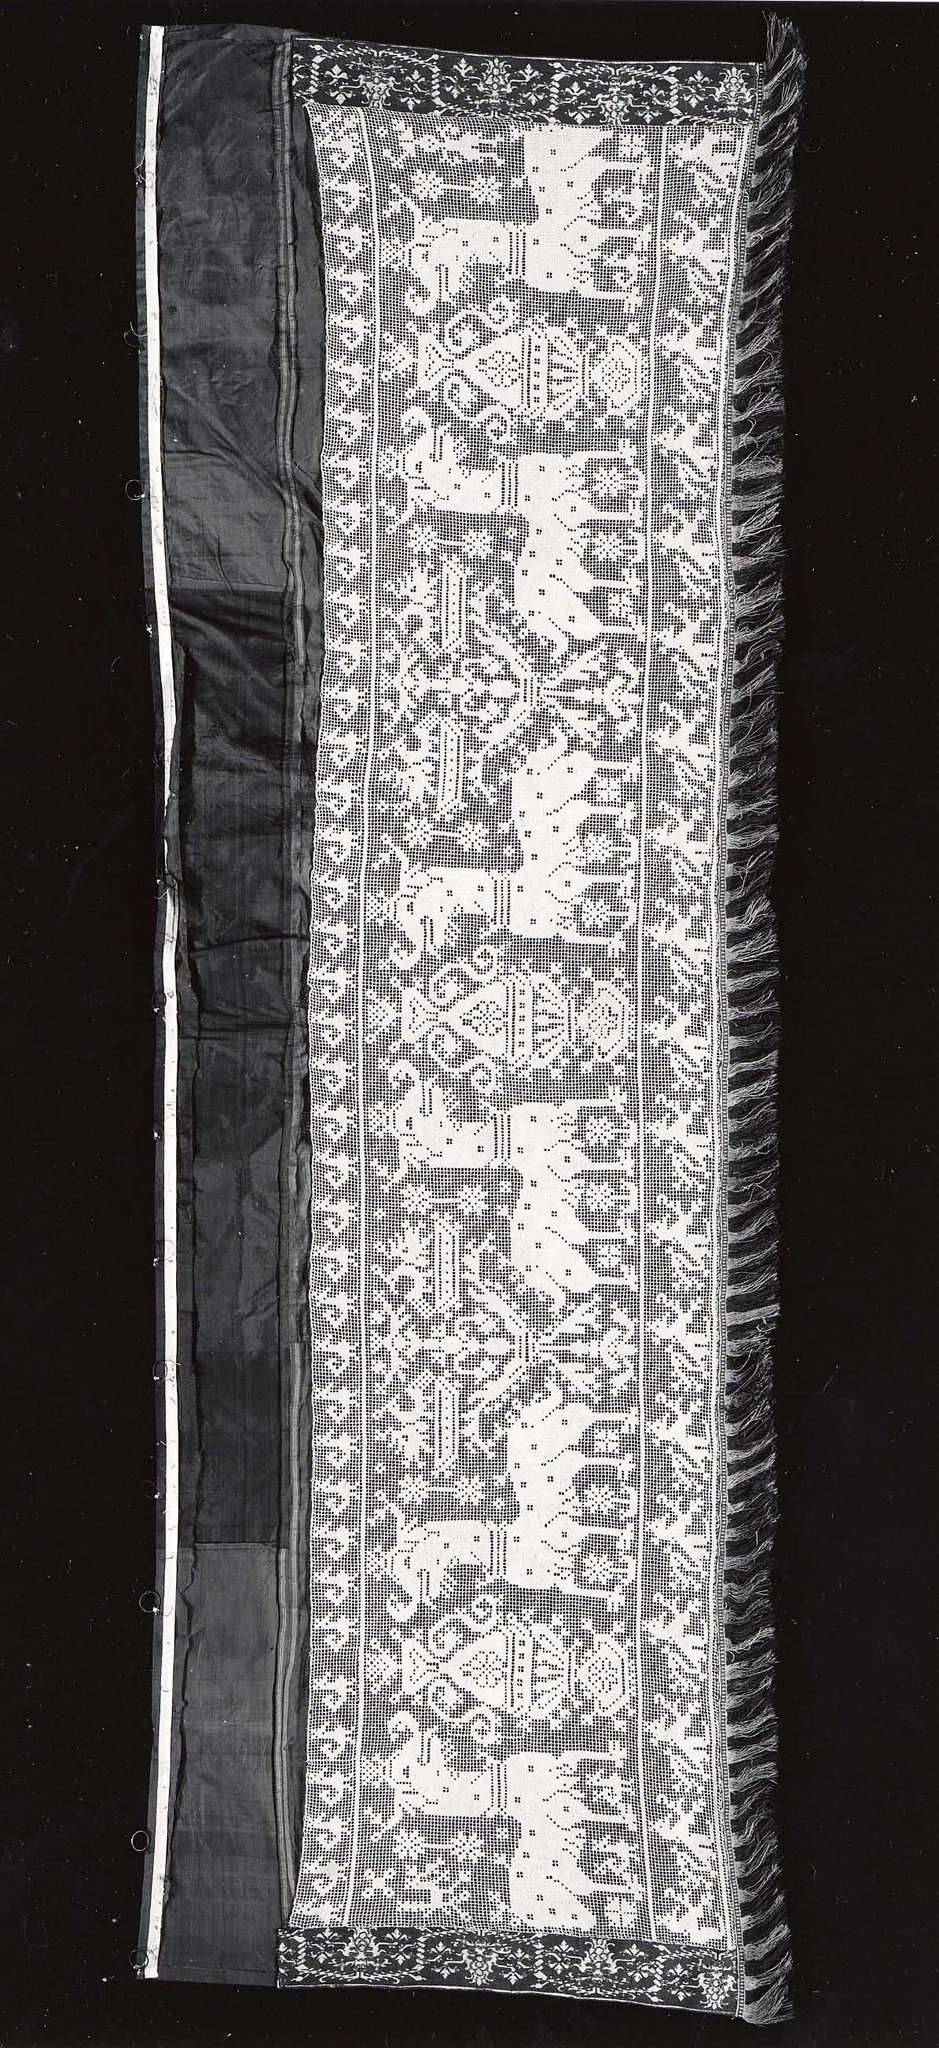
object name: valance or frontal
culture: italian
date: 1601-1700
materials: linen, silk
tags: animals